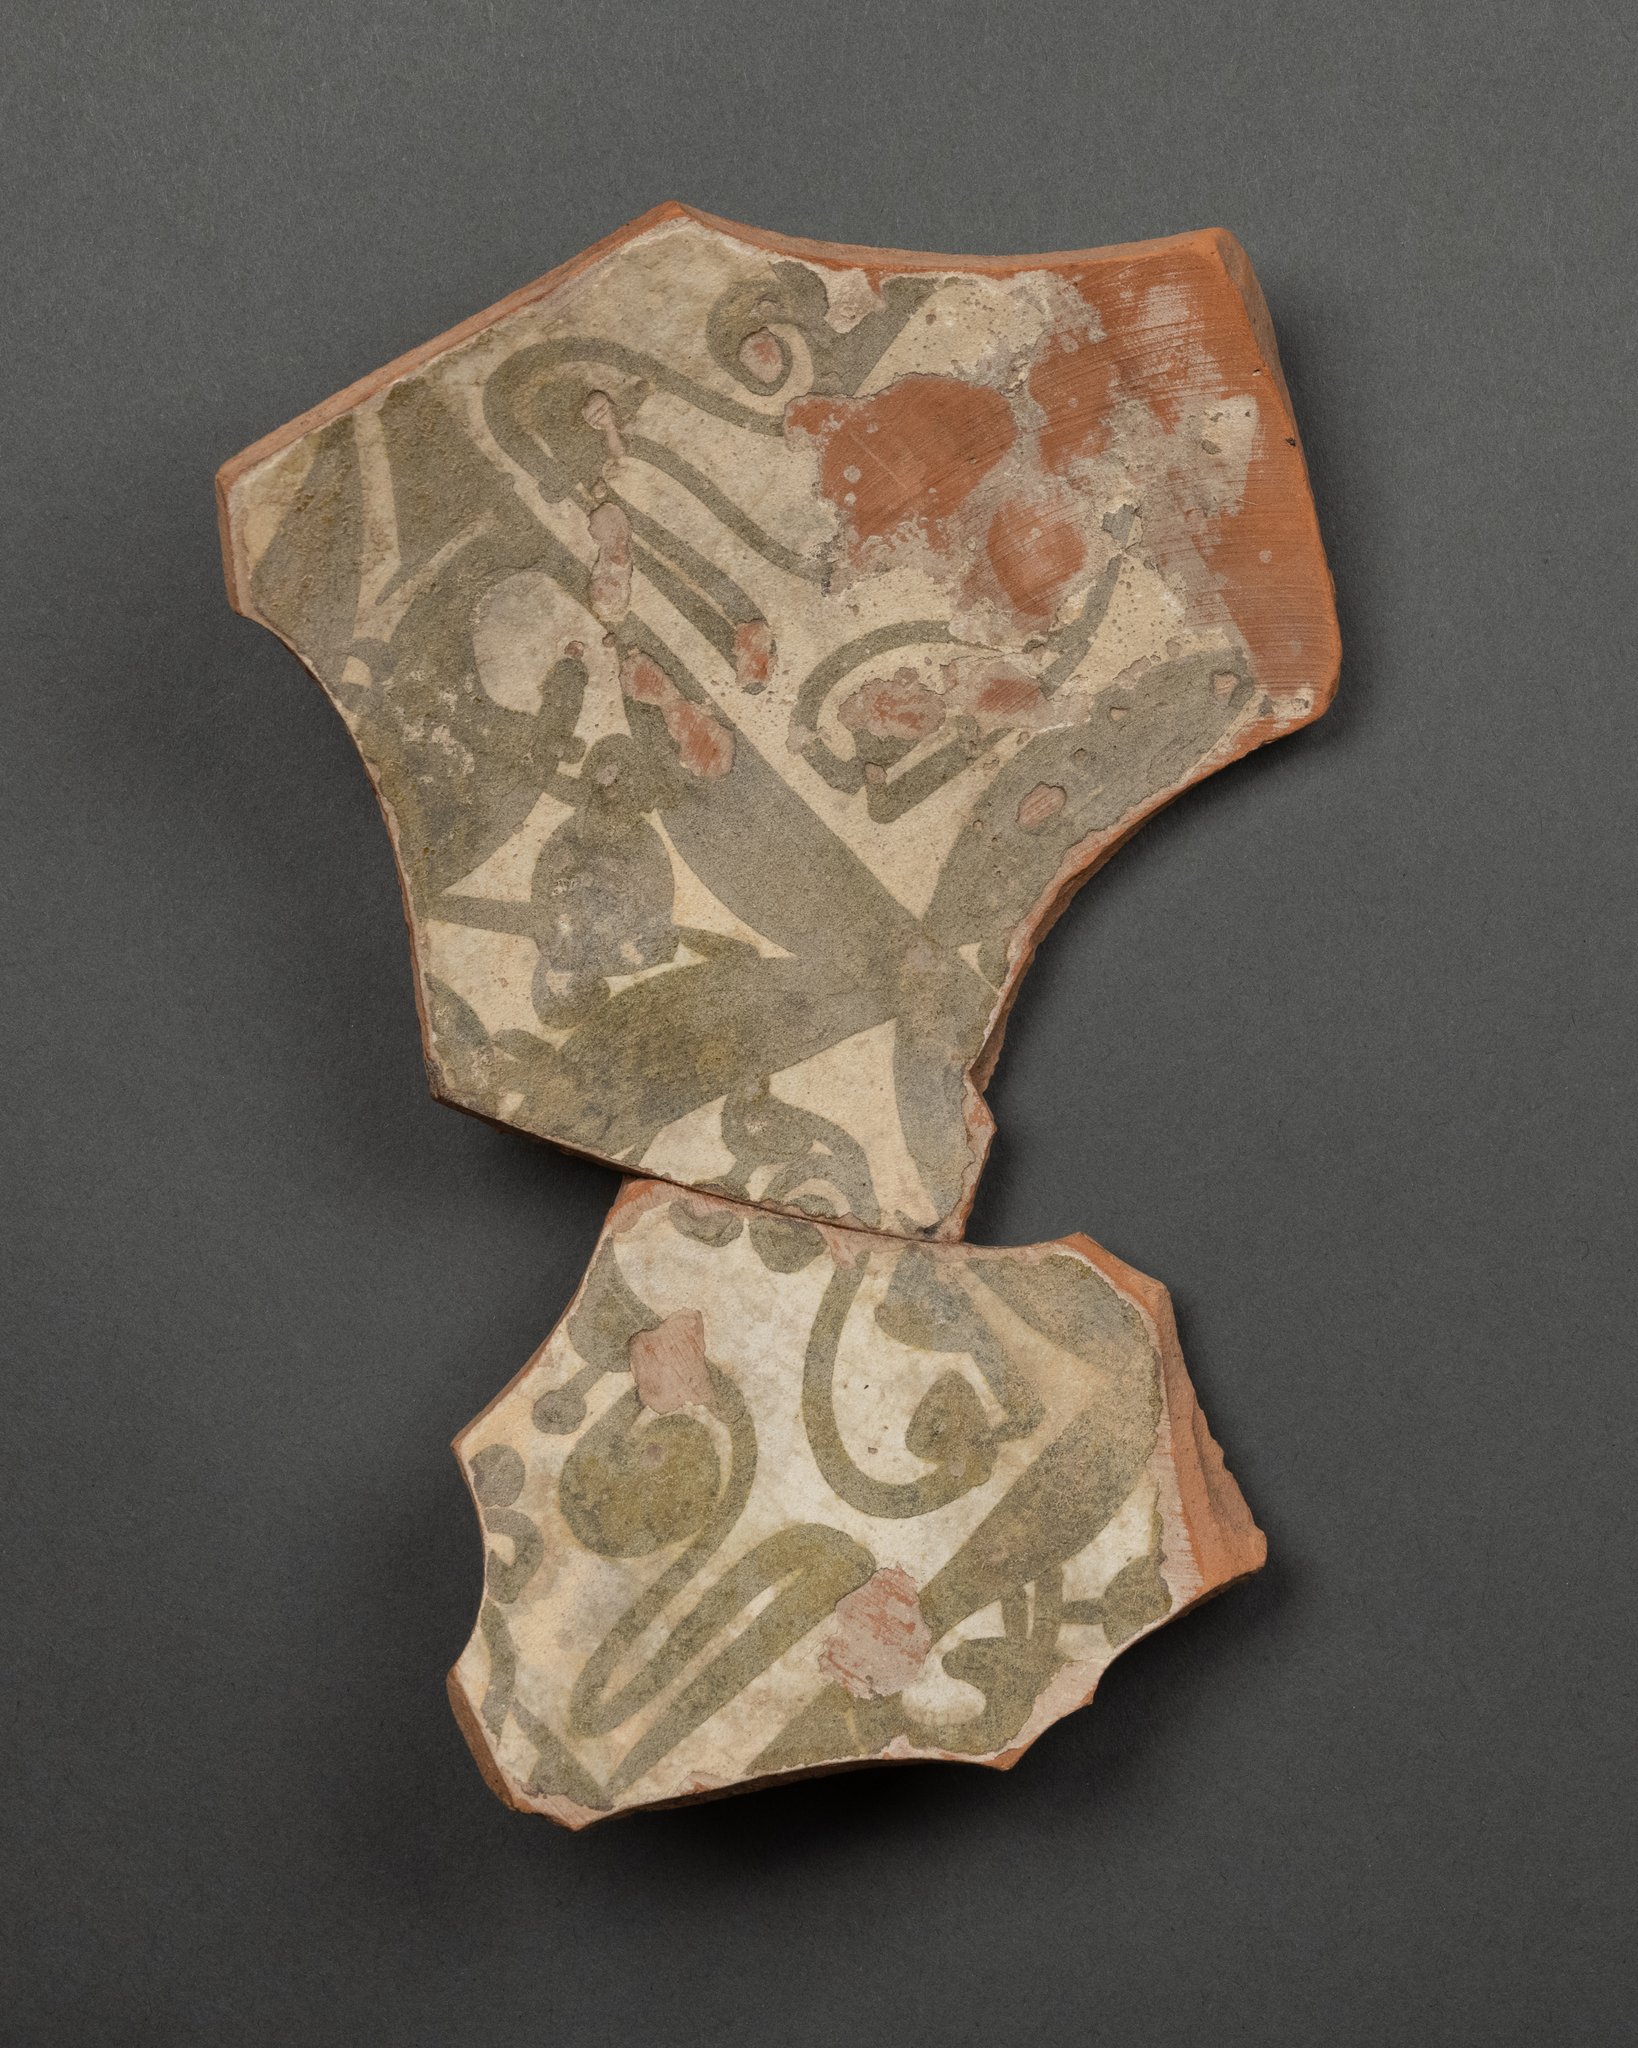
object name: fragment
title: Fragment of a Bowl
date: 801-1000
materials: earthenware, glaze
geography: iran